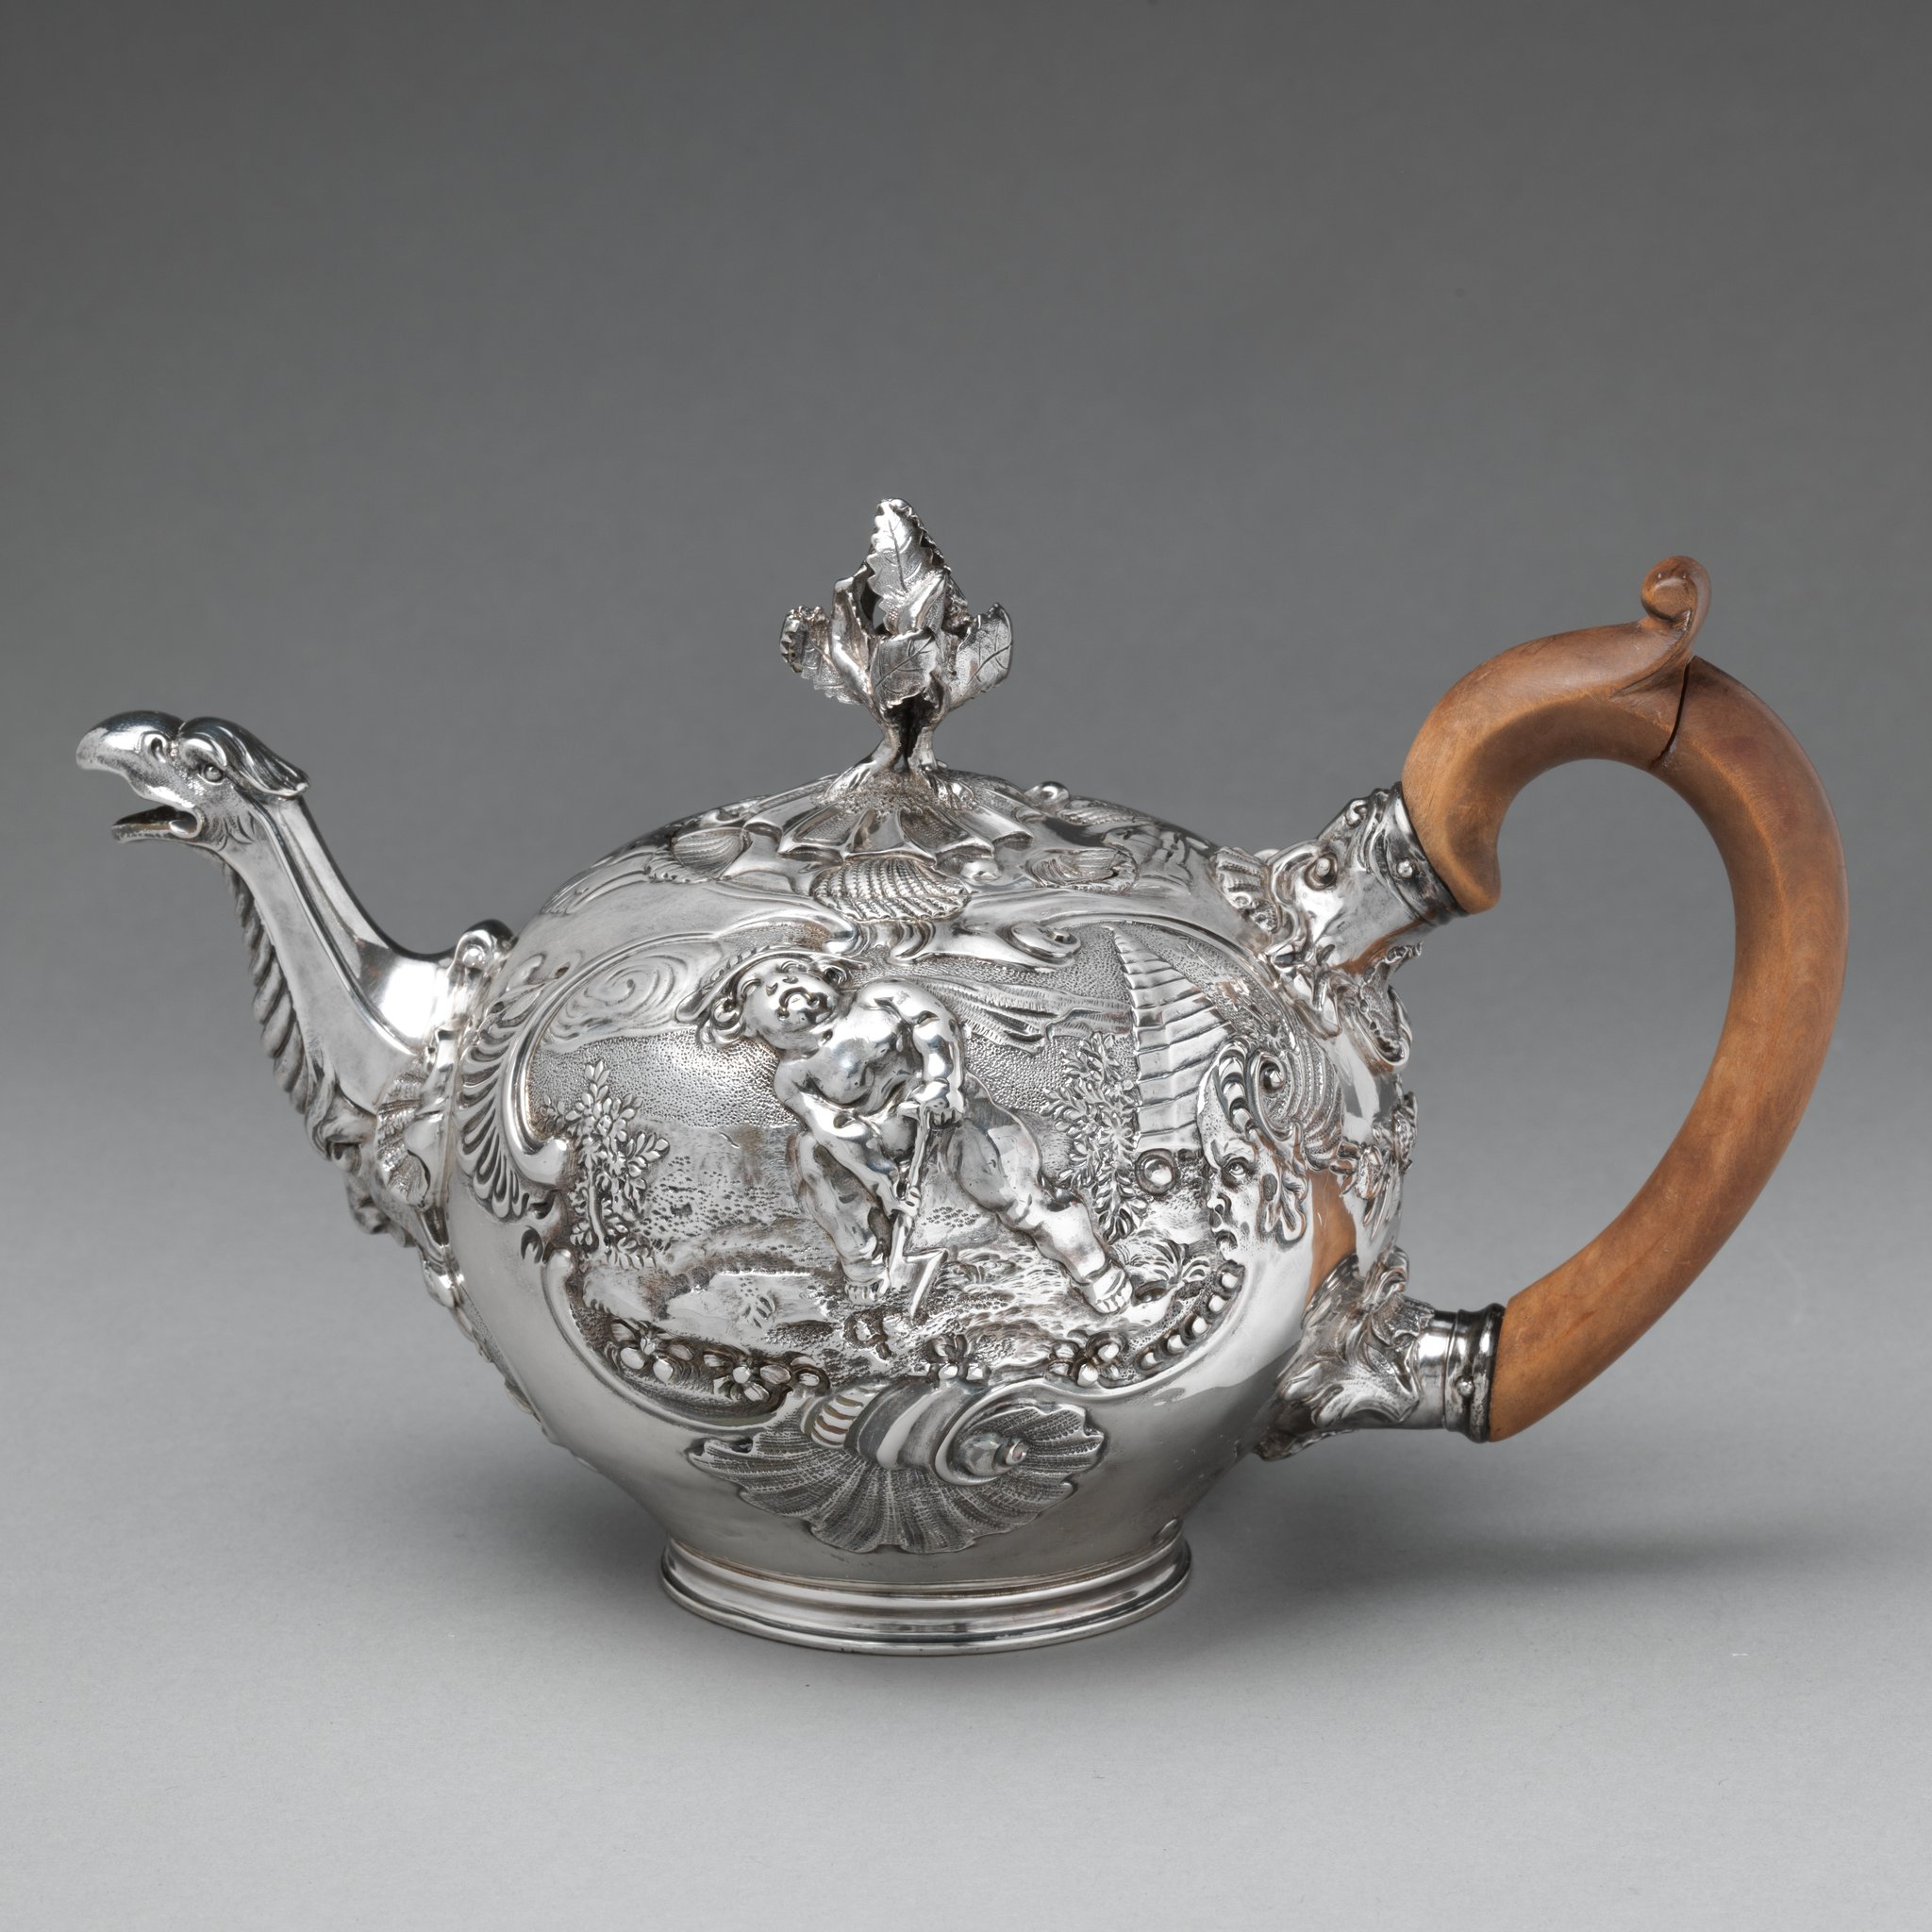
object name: teapot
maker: paul de lamerie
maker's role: maker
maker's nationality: british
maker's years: 1688-1751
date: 1743-1744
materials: silver, wood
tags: putti